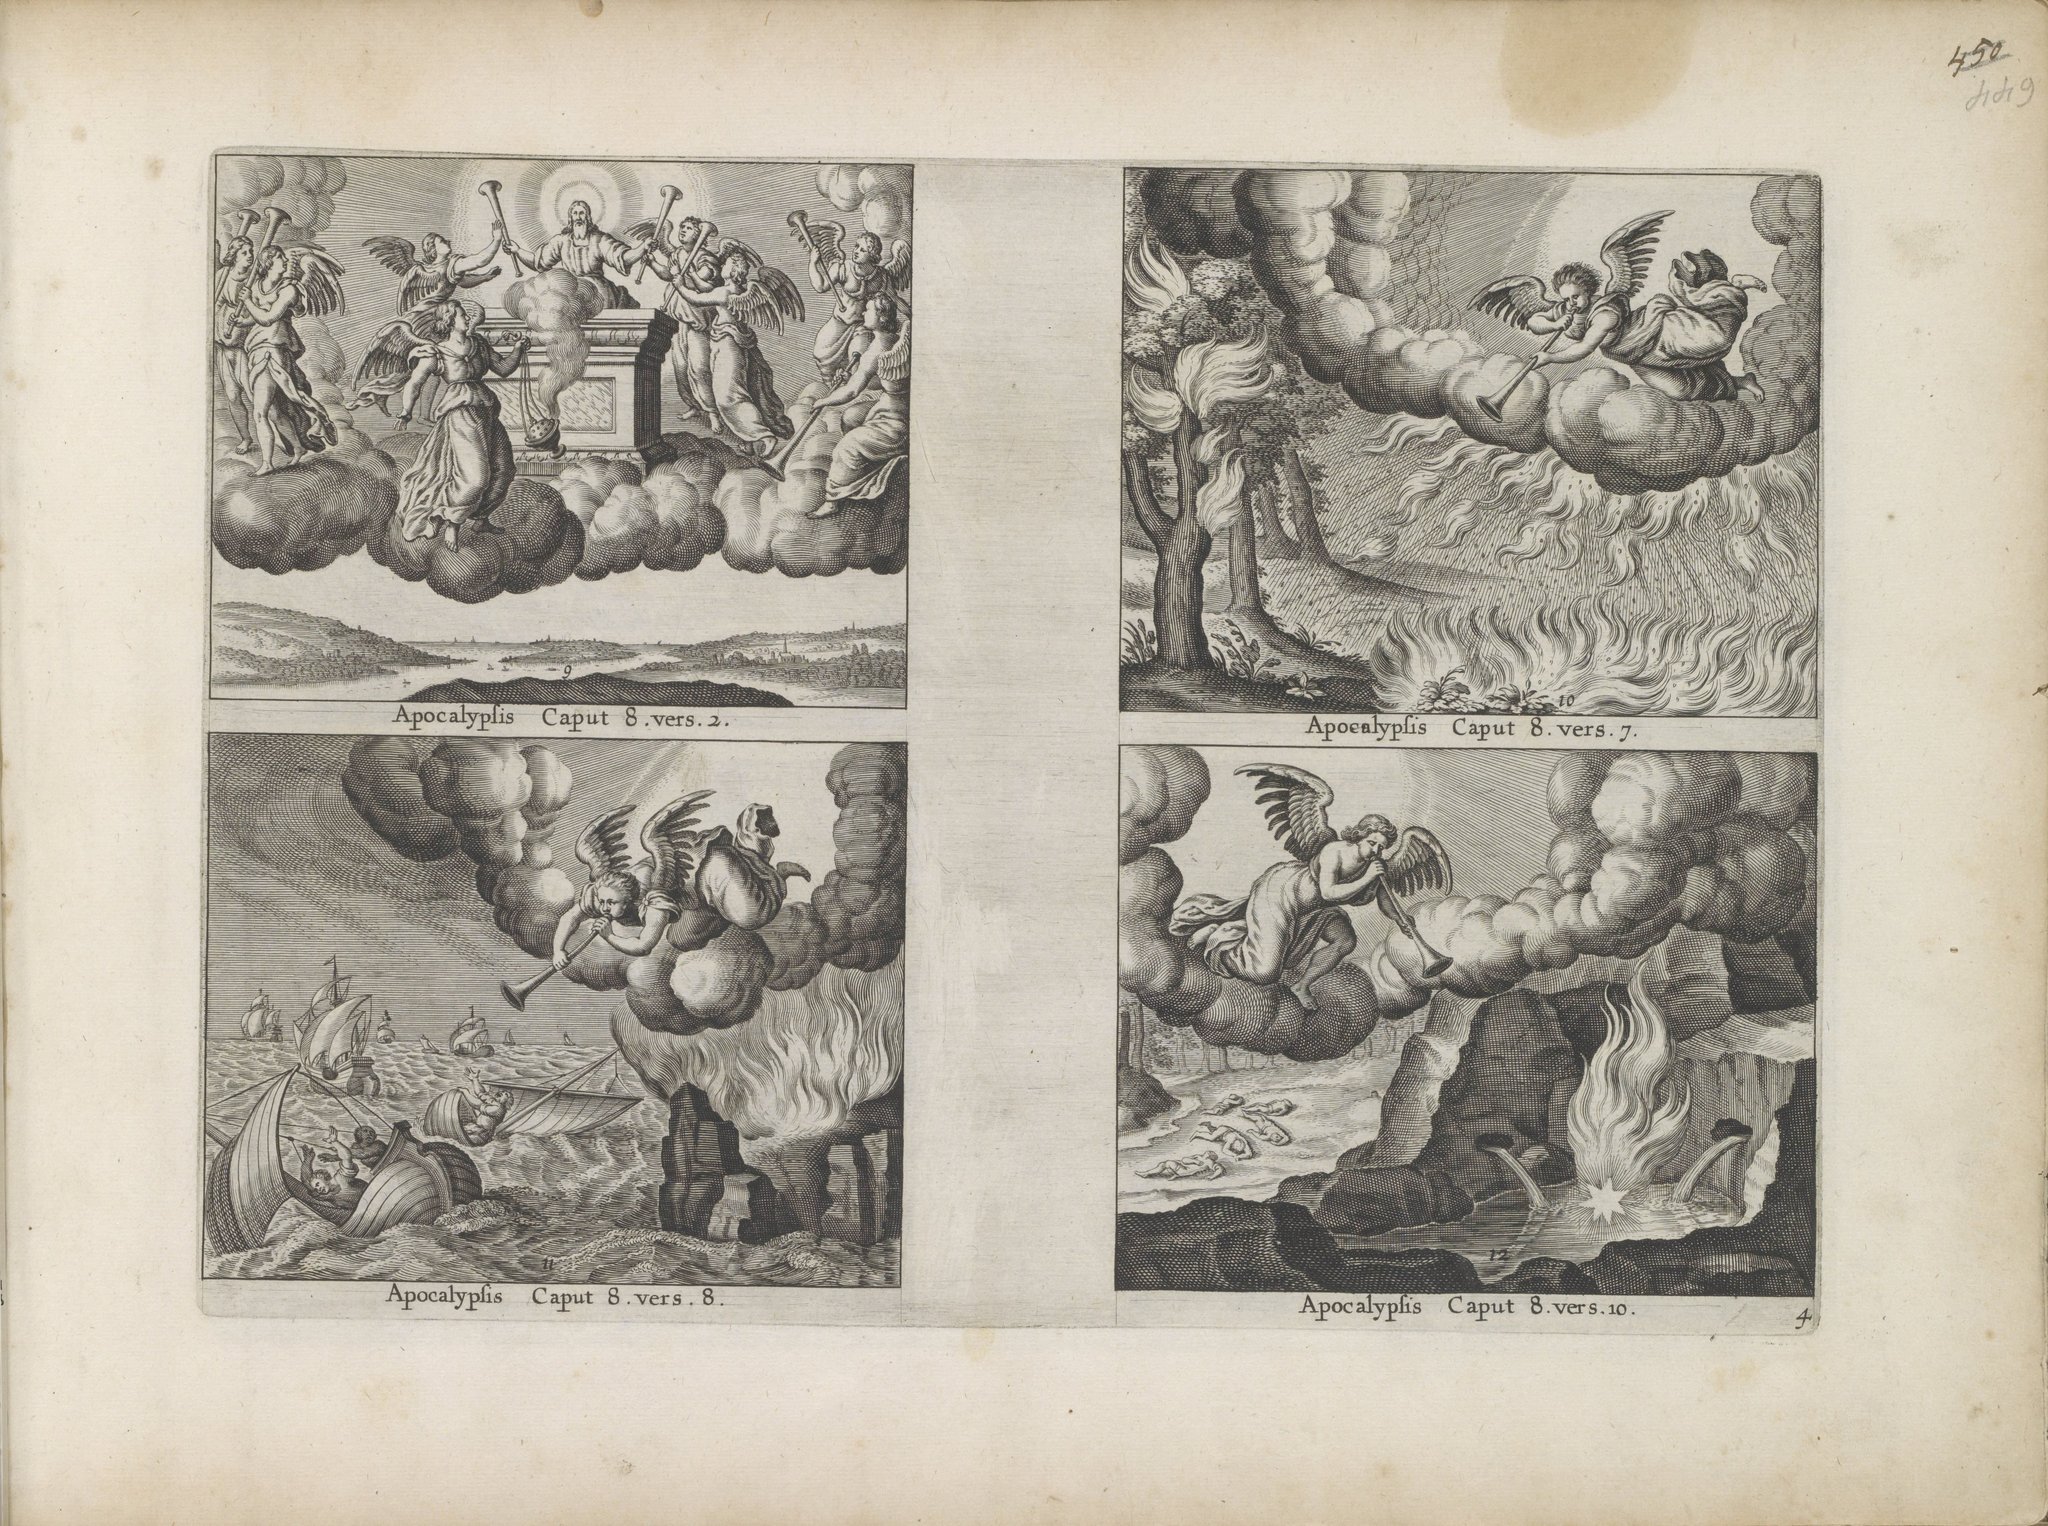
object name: album leaf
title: Openbaring van Johannes op Patmos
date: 1643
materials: paper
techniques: engraving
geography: amsterdam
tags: the seven angels with trumpets ~ revelation of john, the third of the seven angels sounds the trumpet: a great burning star (wormwood) poisons the rivers and fountains, the second of the seven angels sounds the trumpet: a great burning mountain is cast into the sea, the first of the seven angels sounds the trumpet: hail, fire and blood is cast upon the earth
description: Vier genummerde voorstellingen. Linksboven: God de Vader geeft zeven engelen een bazuin. Onder de voorstelling een verwijzing naar de Bijbeltekst in Op. 8:2. Rechtsboven: De eerste van zeven engelen blaast op een bazuin. Hagel en vuur dalen neer op de aarde. Onder de voorstelling een verwijzing naar de Bijbeltekst in Op. 8:7. Linksonder: De tweede engel blaast op de bazuin. Een berg waar de vlammen uitslaan wordt in zee geworpen. Onder de voorstelling een verwijzing naar de Bijbeltekst in Op. 8:8. Rechtsonder: De derde engel blaast op de bazuin. Een grote ster valt in de waterbron en maakt het water bitter. Onder de voorstelling een verwijzing naar de Bijbeltekst in Op. 8:10. Deze prent maakt deel uit van een album.